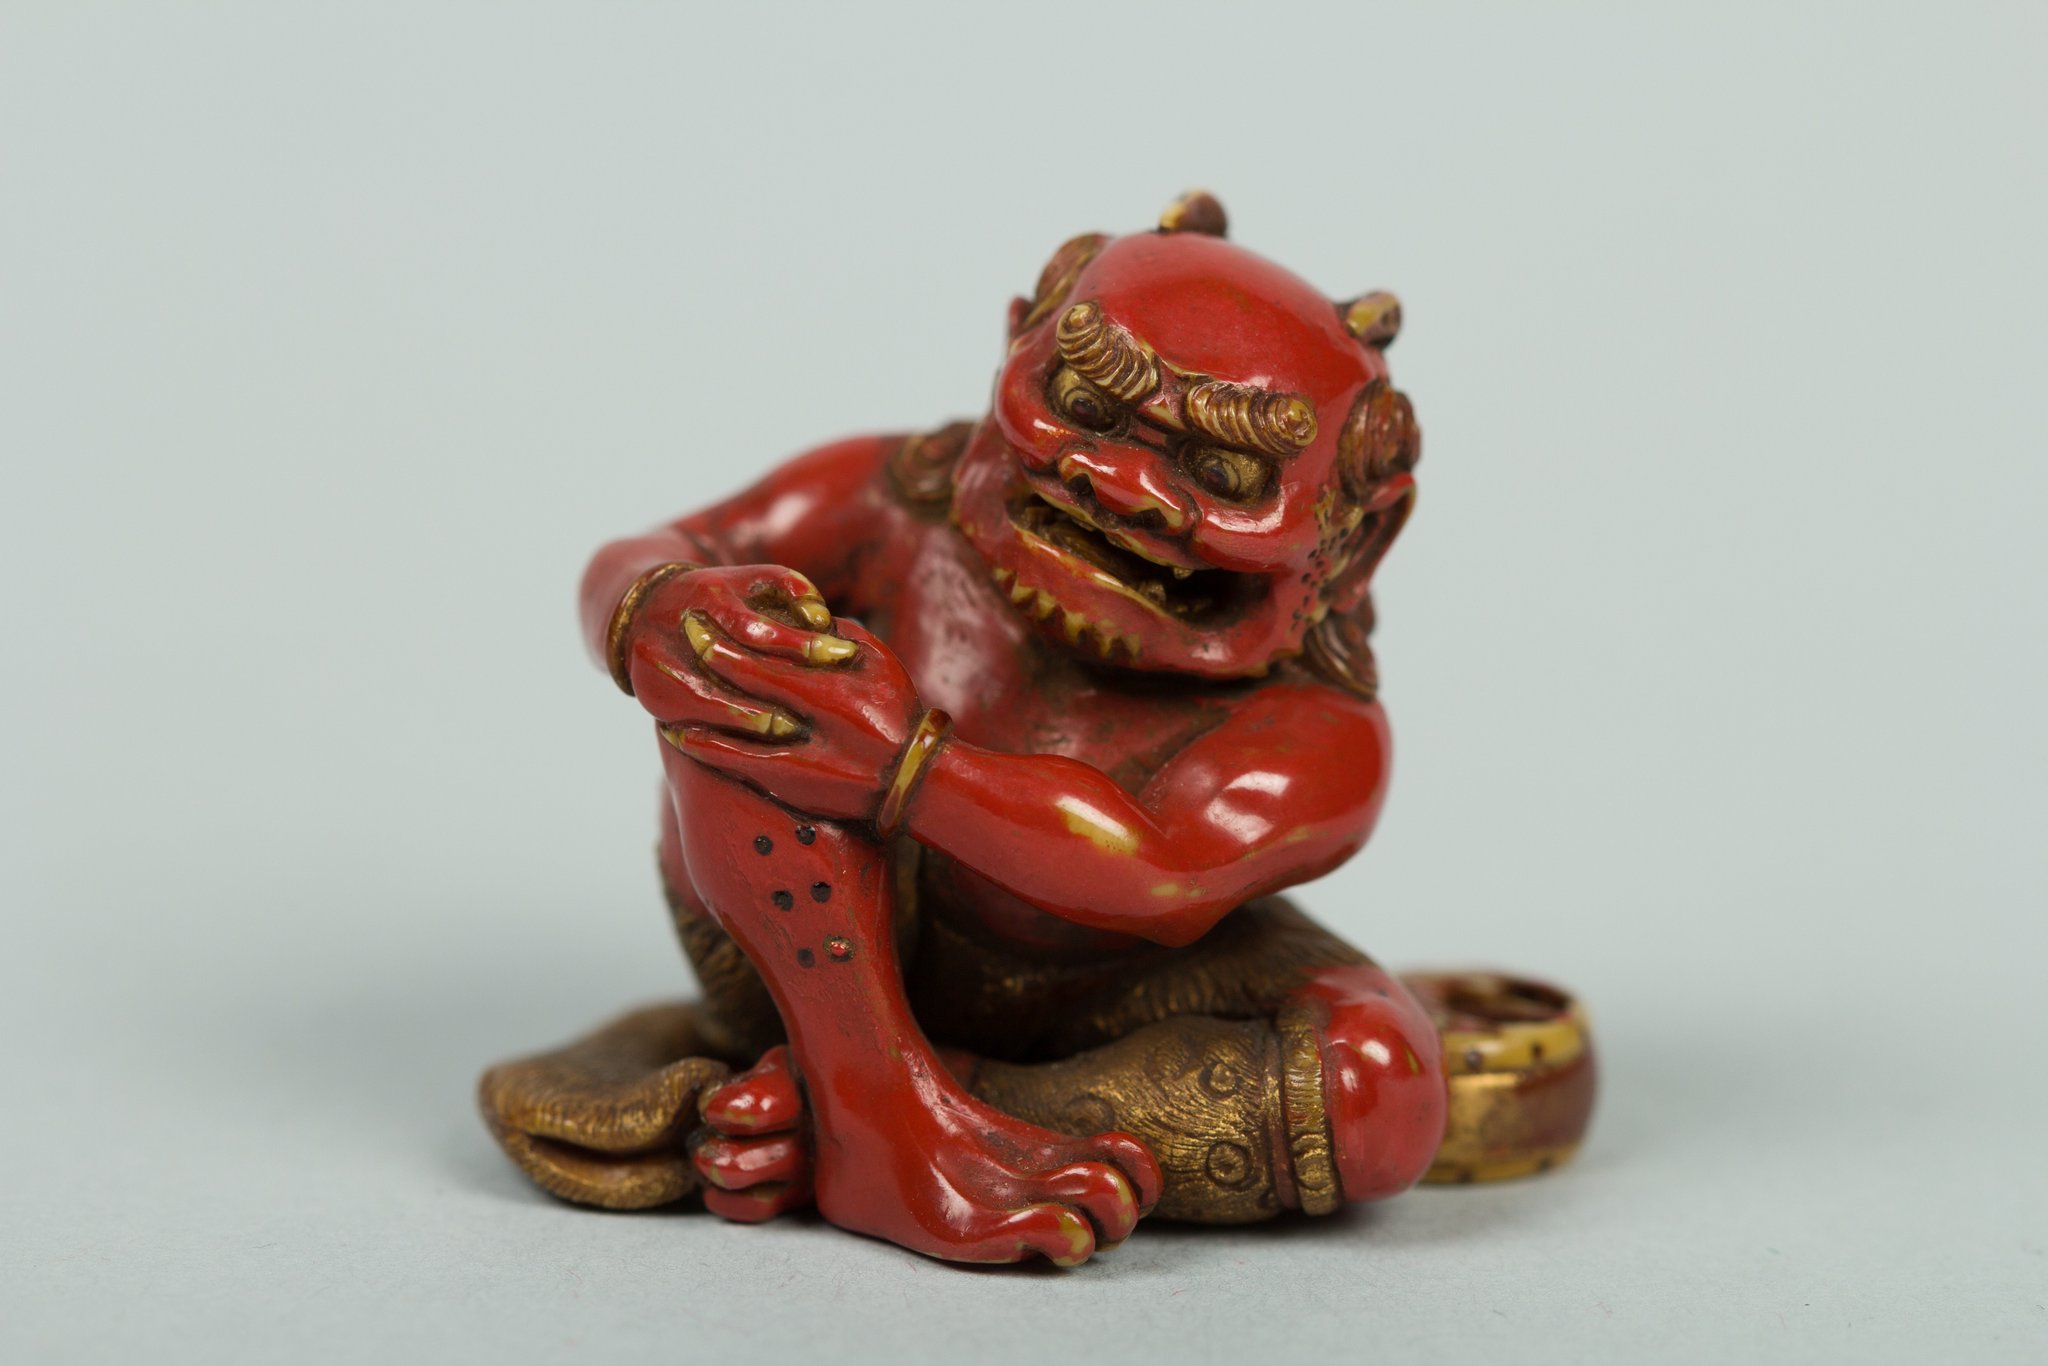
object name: netsuke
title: Netsuke of Demon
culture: japanese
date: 1801-1900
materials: lacquer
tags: demons